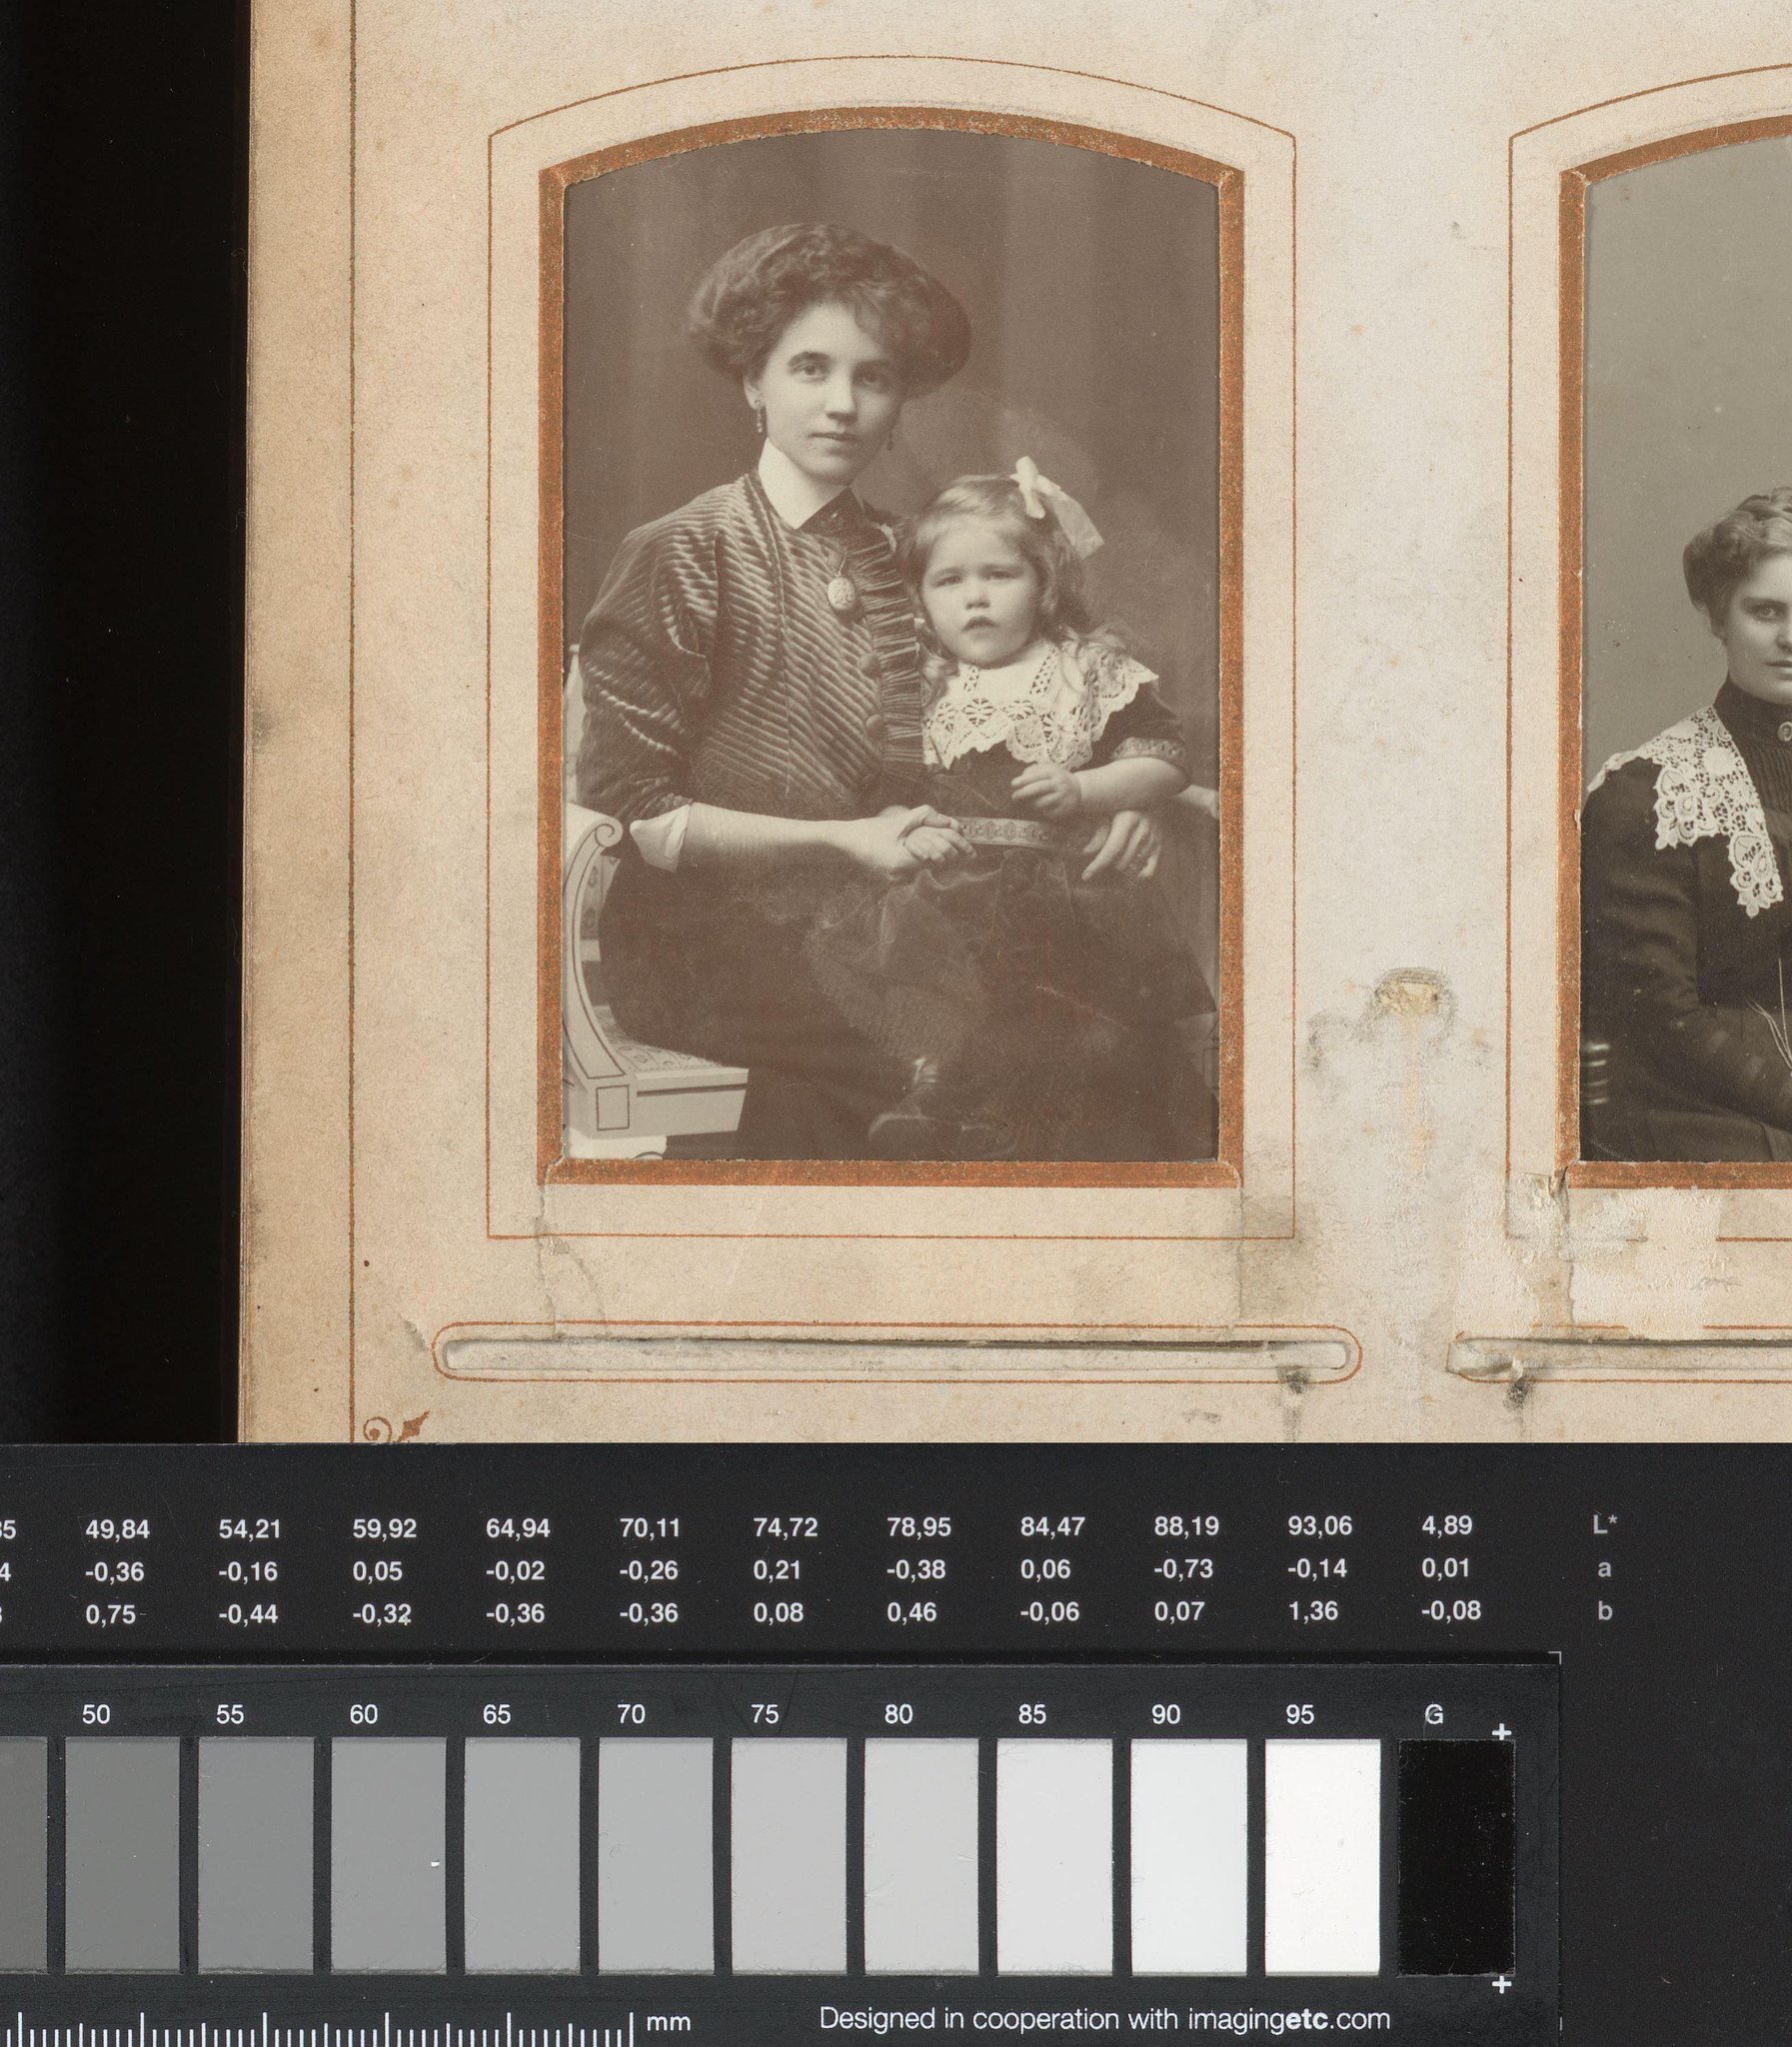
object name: album leaf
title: Portret van een zittende vrouw met kind op schoot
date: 1880-1920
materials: cardboard, photographic support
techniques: collodion silver print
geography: stockholm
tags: sitting figure - aa - female human figure, historical persons - bb - woman, toddler (female)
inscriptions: inscription: ‘ATELIER GÖTA/ Götgatan 71./ STOCKHOLM.’